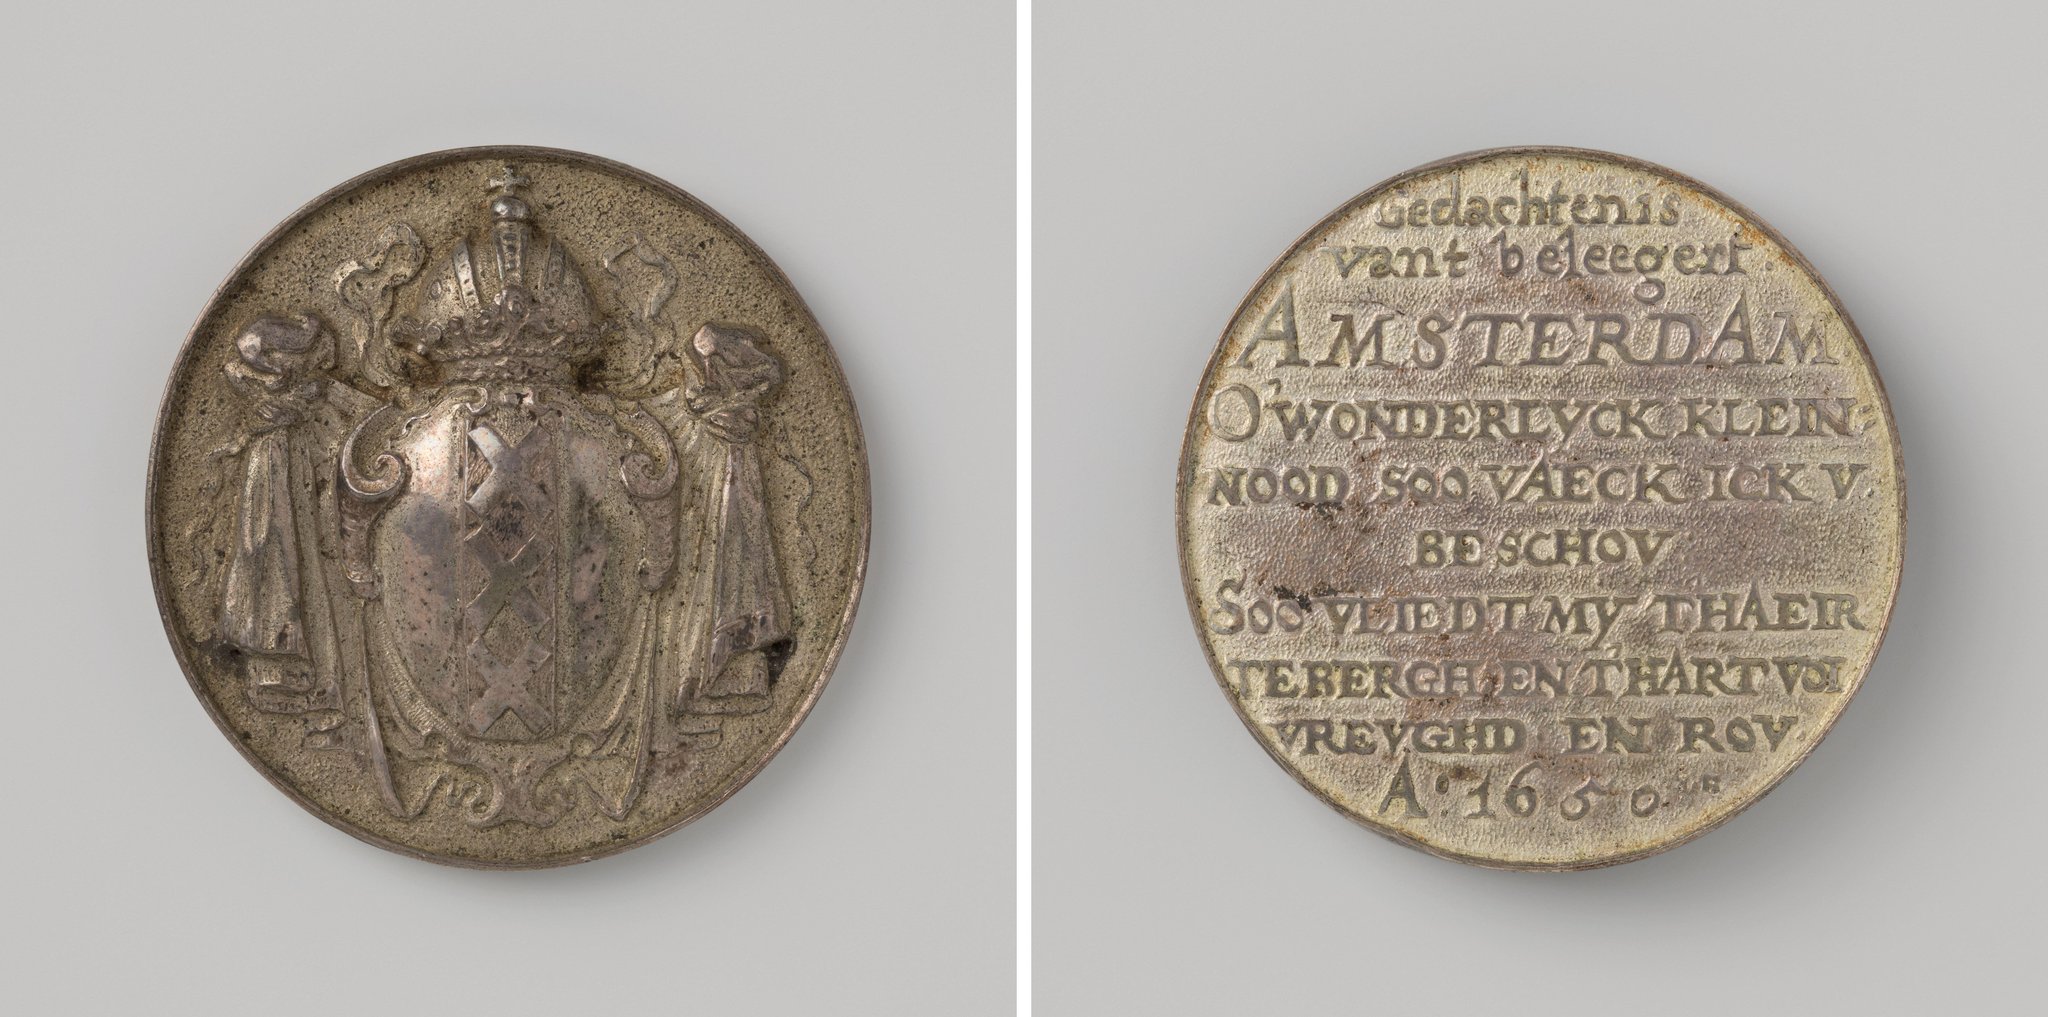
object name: history medal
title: Beleg van Amsterdam door Prins Willem II 1650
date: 1650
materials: silver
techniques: casting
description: Zilveren plaquettepenning, op de voorzijde in hoog relief het gekroonde Amsterdamse wapenschild op een mantel, op de keerzijde tien regels tekst.